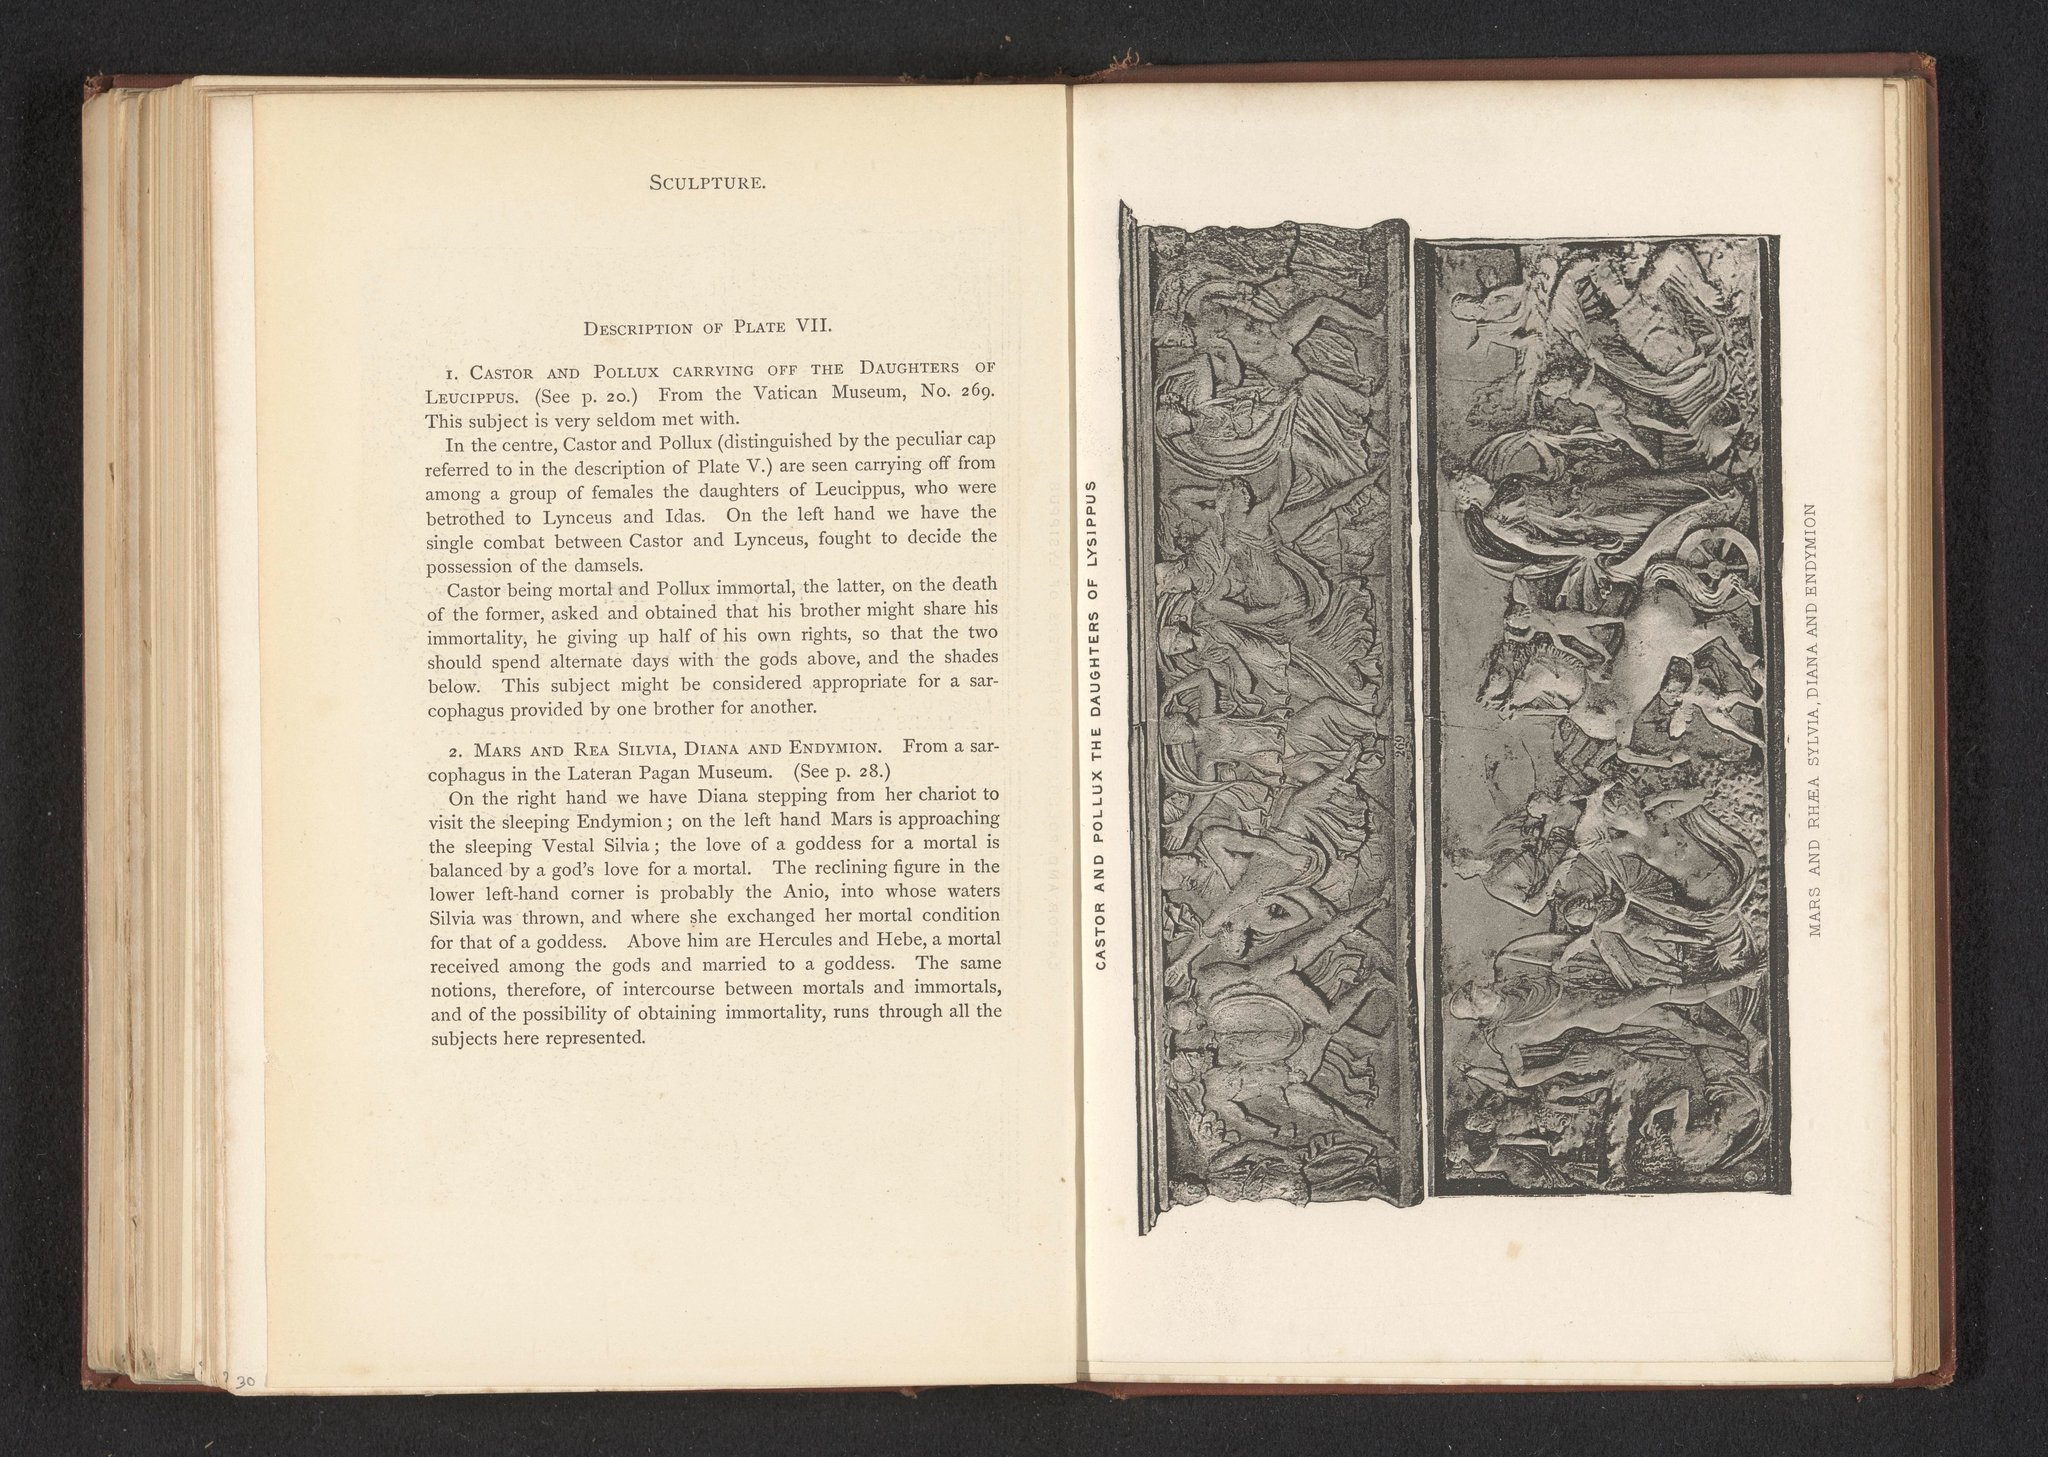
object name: page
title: Castor and Pollux the daughters of Lysippus Mars and Rhea, Diana and Endymion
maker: Anonymous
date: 1867-1877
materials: paper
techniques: photoaquatint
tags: diana (luna) visiting the sleeping endymion, mars woos rhea silvia, who may be seen sleeping on the tiber bank, with a water-jug beside her, sarcophagus, decorating 'en relief', appliquéing, (story of) the dioscuri: castor (the horse-tamer) and pollux (the boxer)